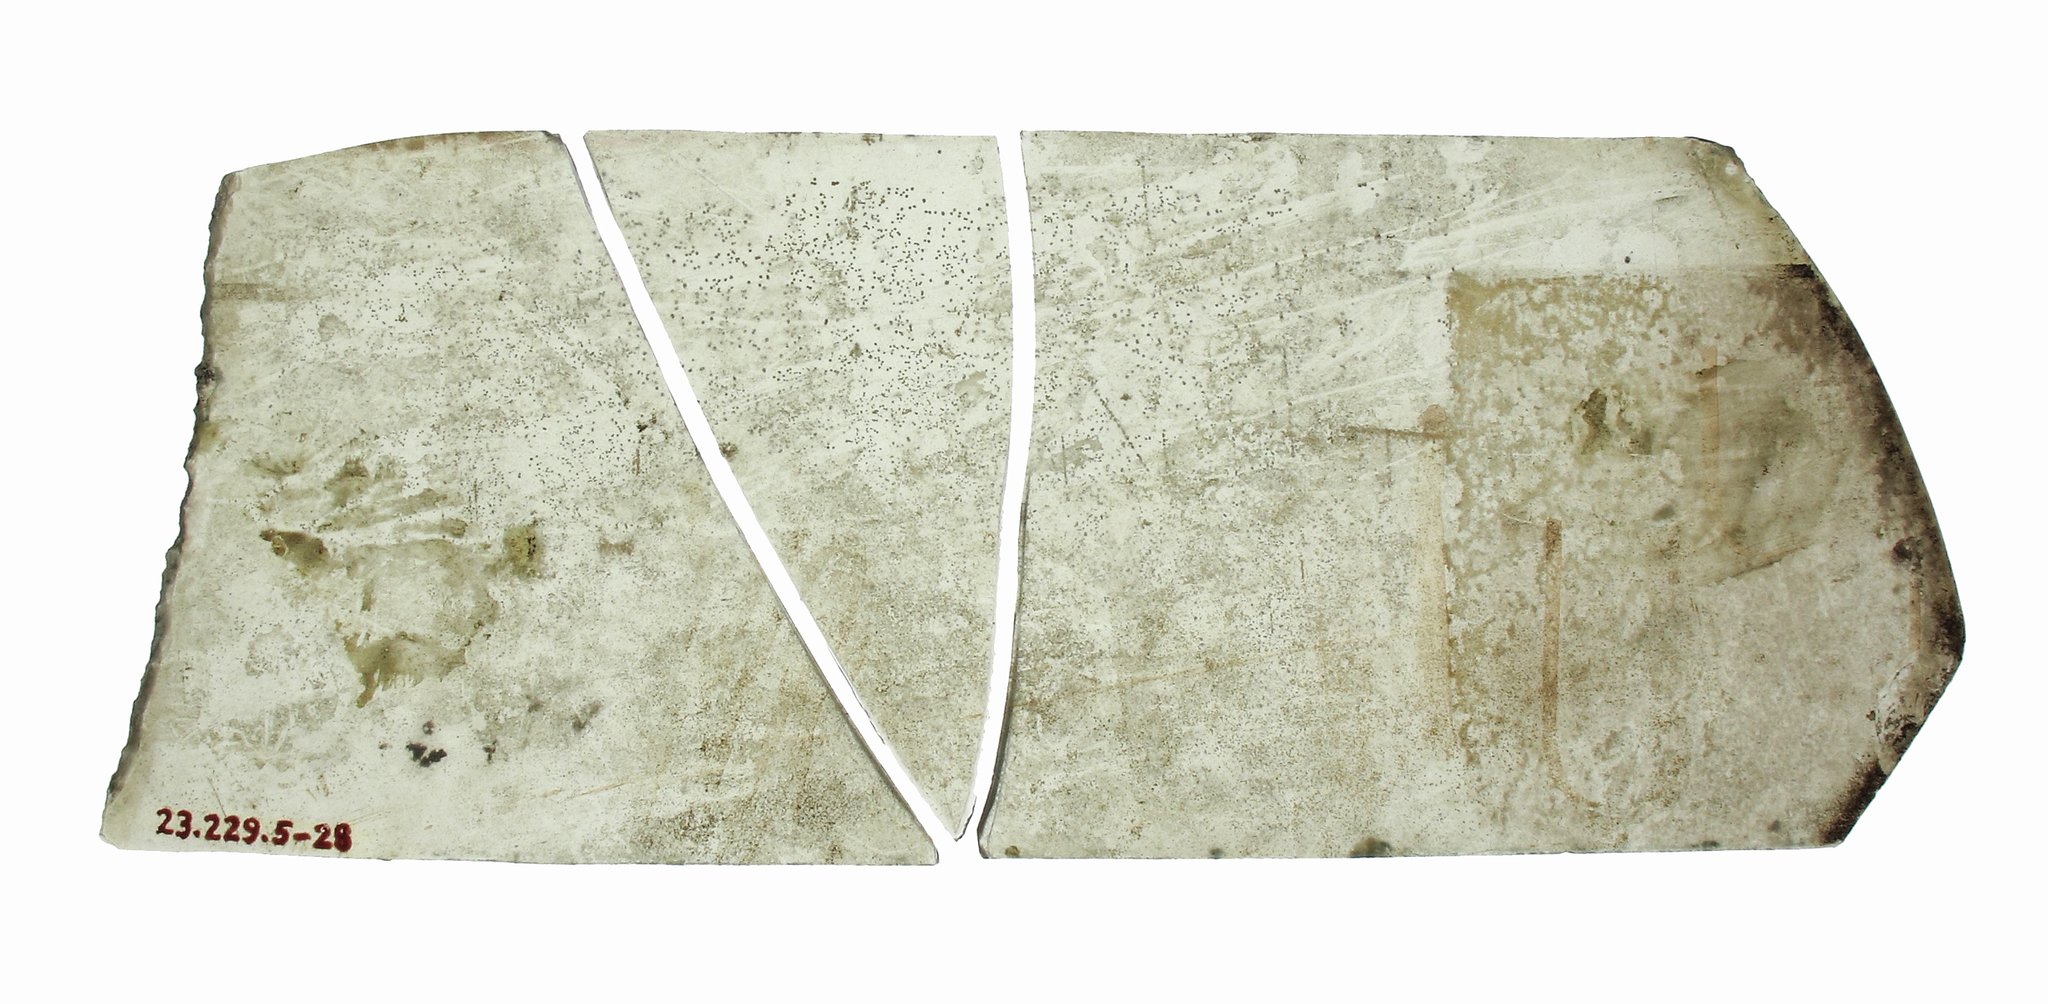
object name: fragment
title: Glass Fragment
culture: french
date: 1501-1600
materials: glass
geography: france